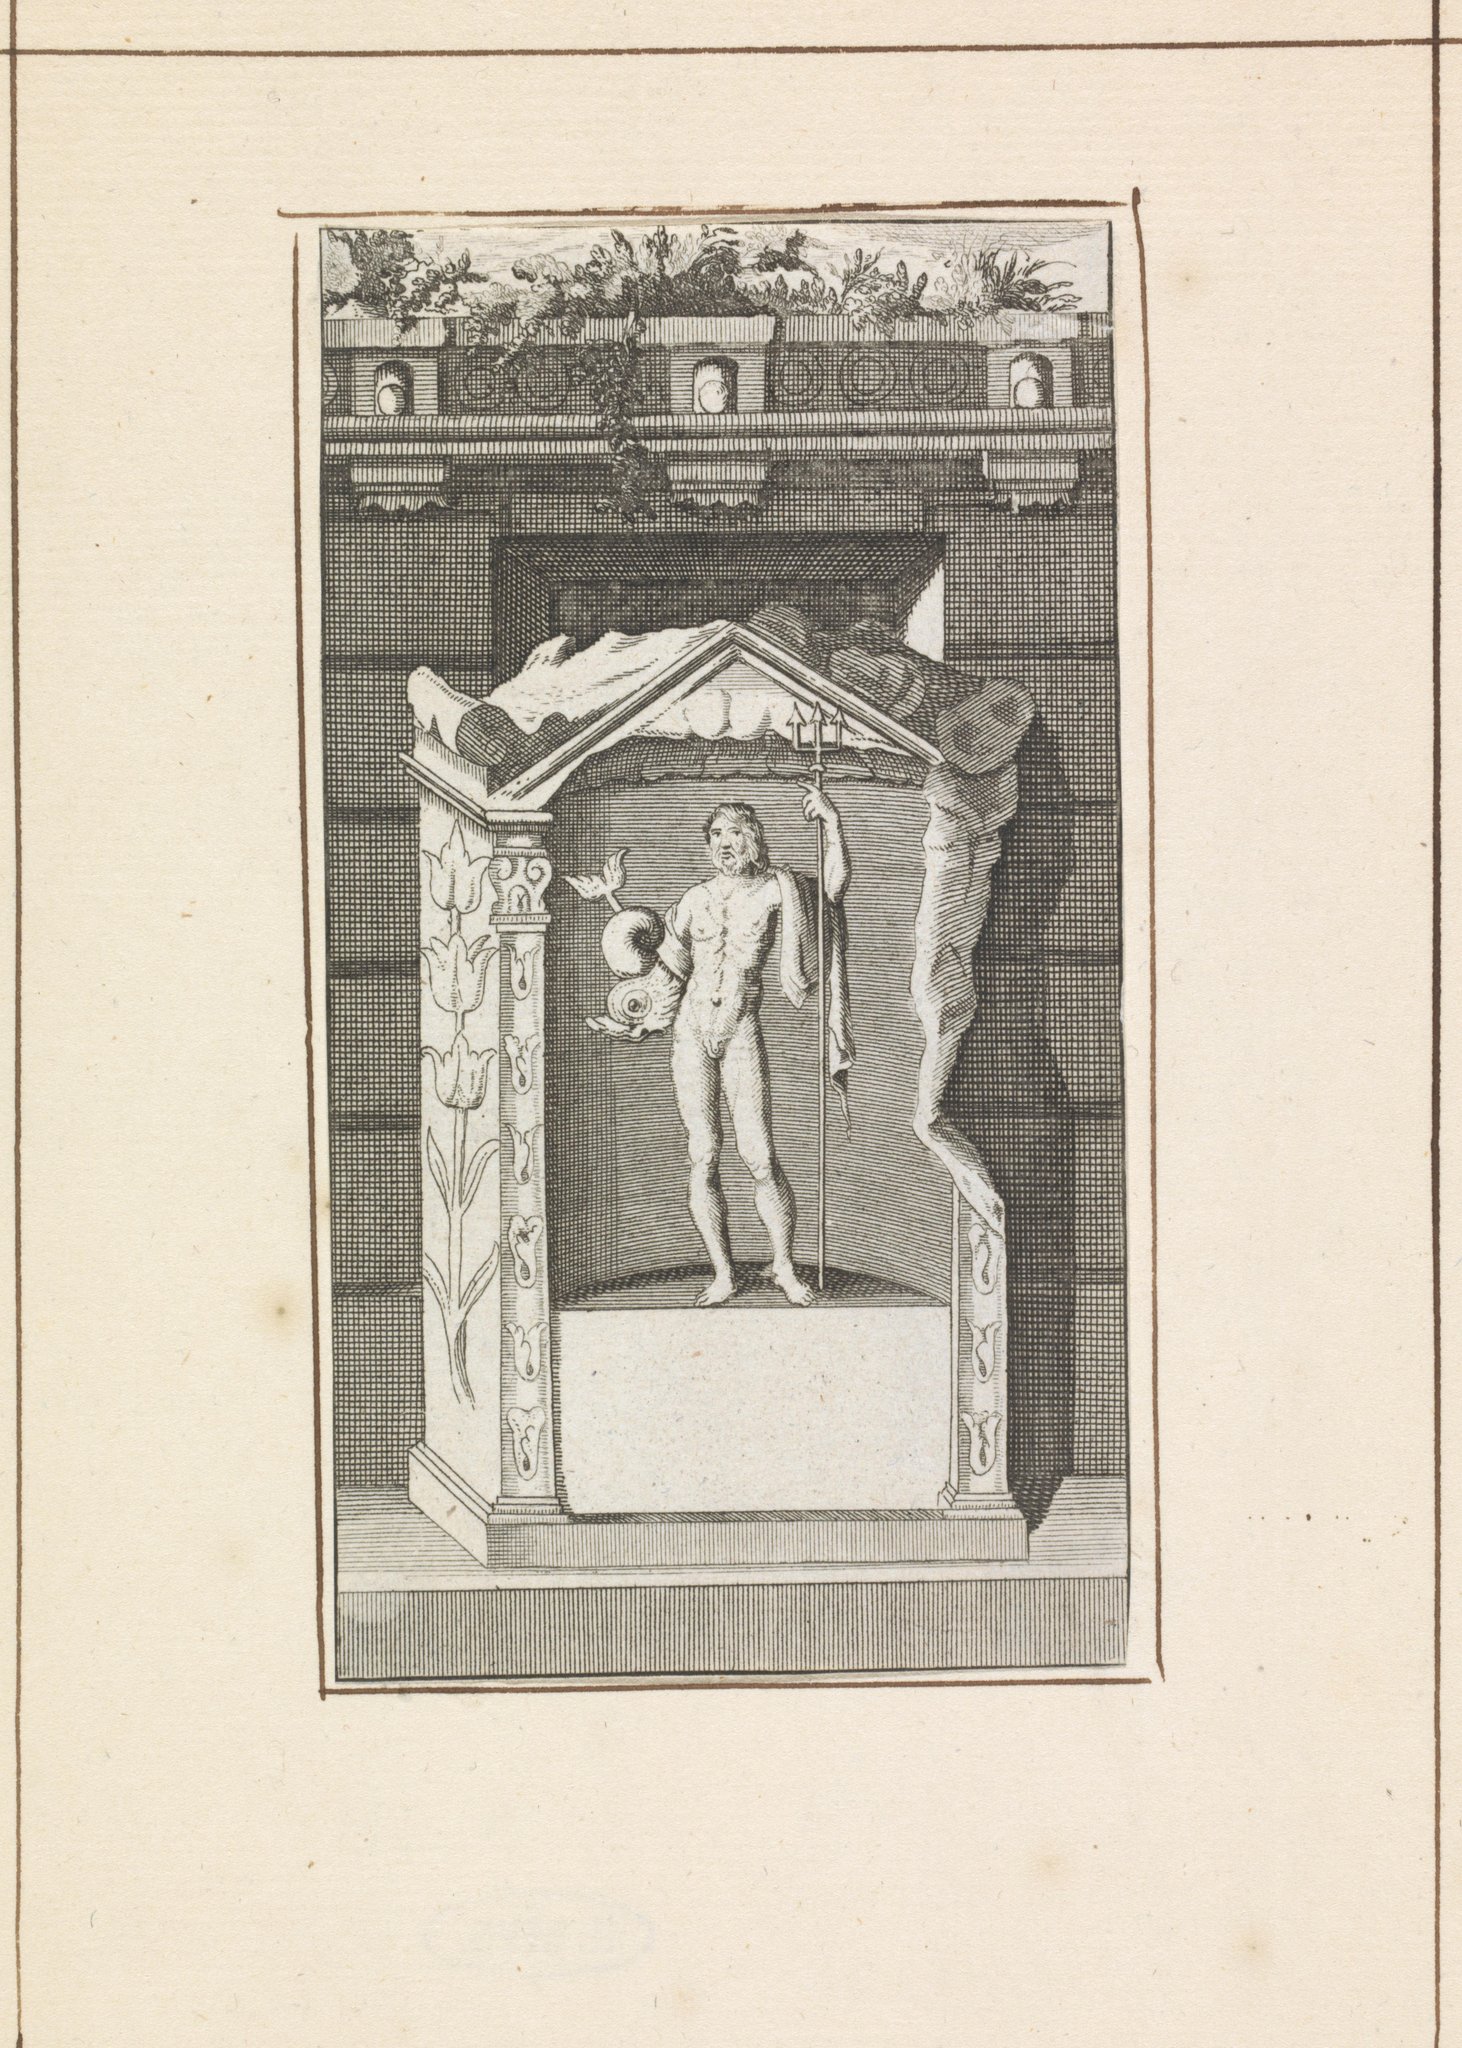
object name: print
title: Neptunus-altaar gevonden bij Domburg op Walcheren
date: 1715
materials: paper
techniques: etching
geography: leiden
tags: (story of) neptune (poseidon)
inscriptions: collector's mark: Lugt 2228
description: Een Neptunus-altaar dat is gevonden bij Domburg op Walcheren. De god Neptunus staande met in de ene hand een vis en in de andere hand zijn drietand.